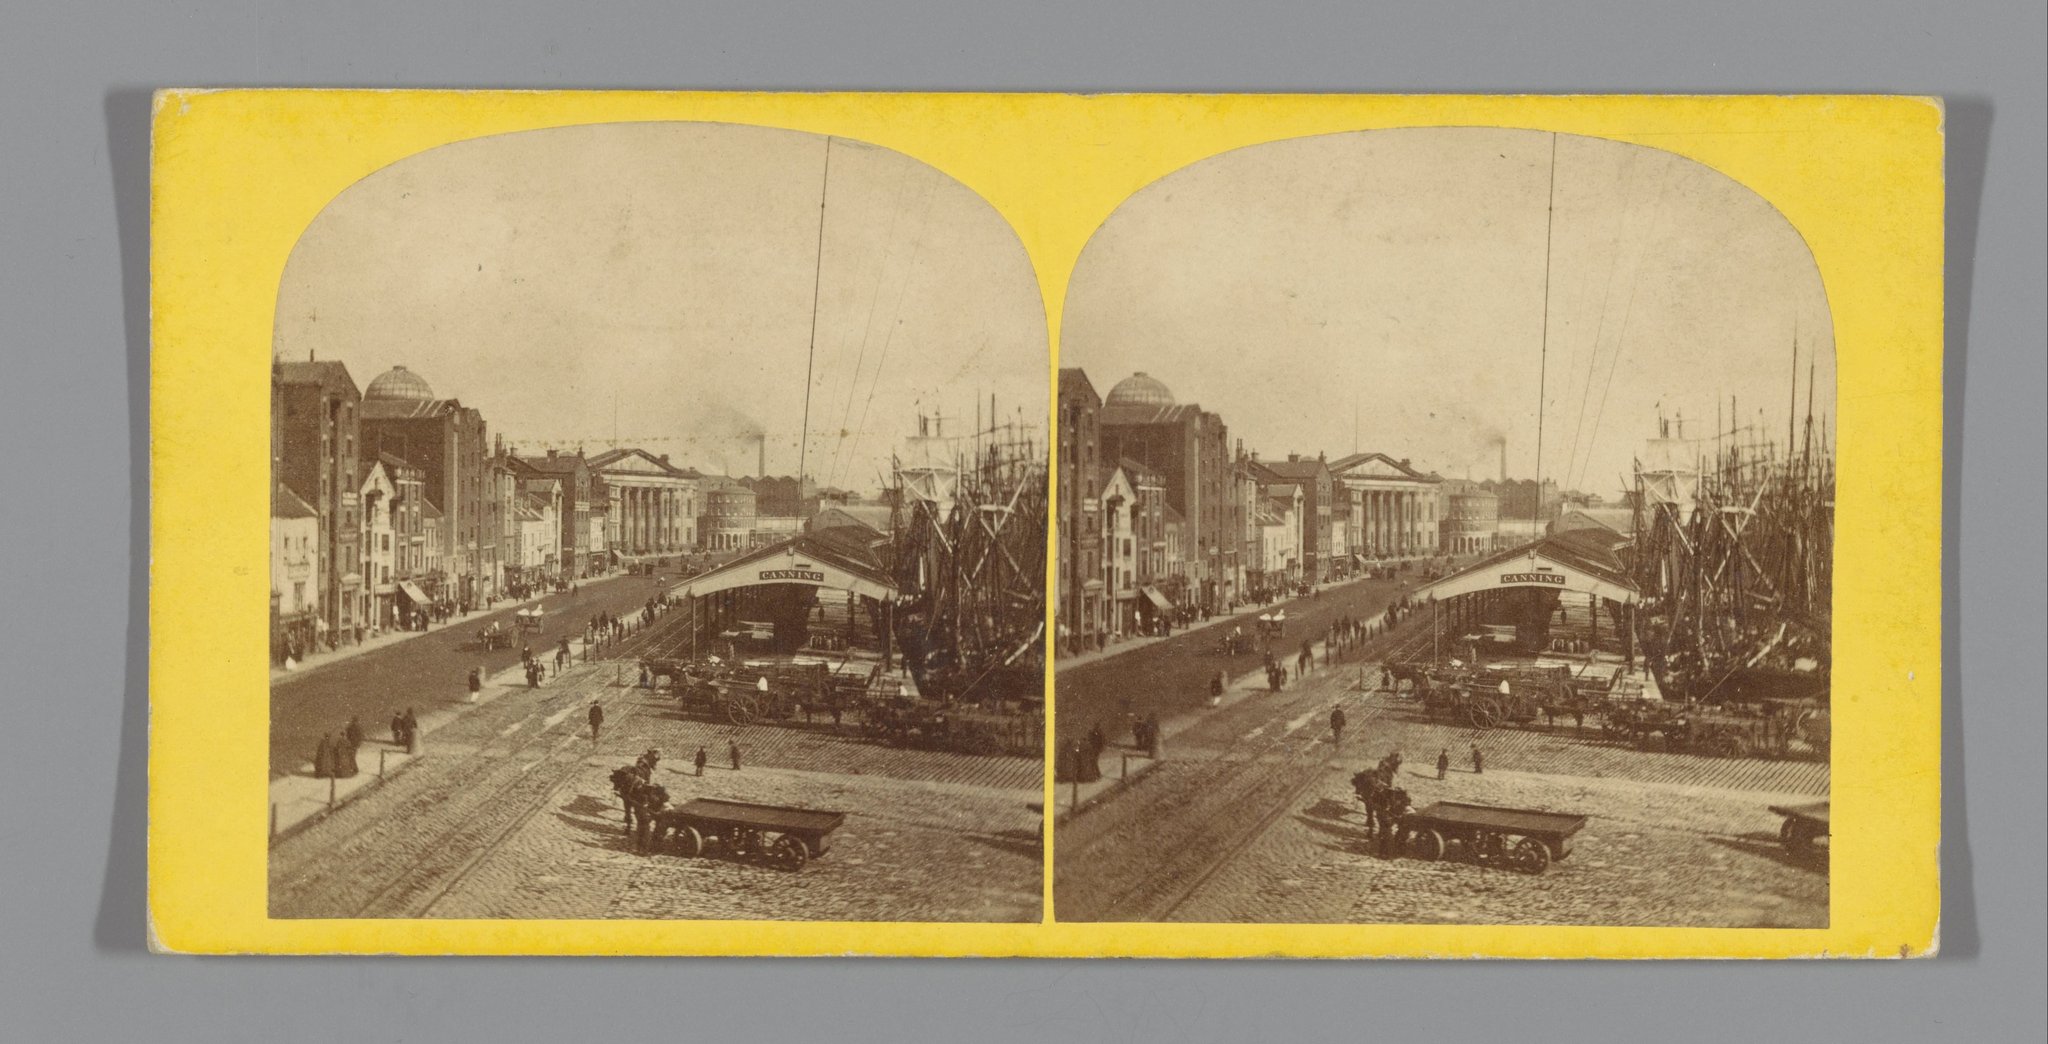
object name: stereograph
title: Strand-street, Liverpool.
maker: henry sampson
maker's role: fotograaf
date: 1850-1880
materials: cardboard, photographic support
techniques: albumen print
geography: liverpool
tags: façade (of house or building), street, liverpool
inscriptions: number: ‘No. 47.’, name: ‘H. Sampson, Photographer, Southport.’